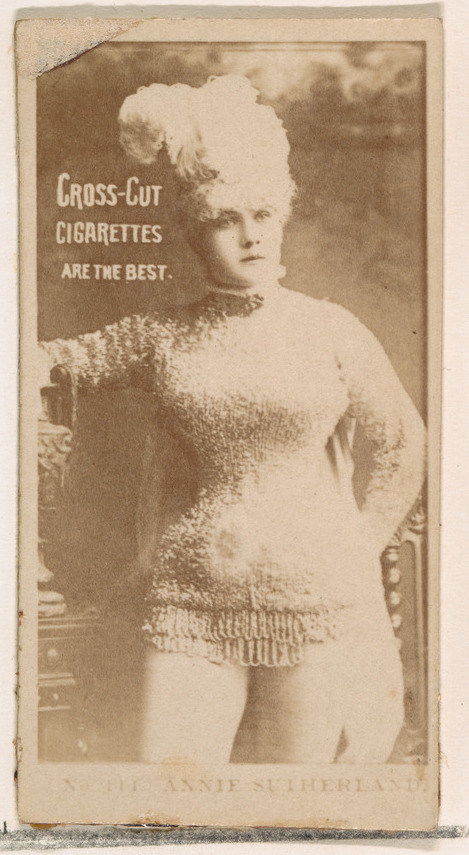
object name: print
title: Annie Sutherland, from the Actors and Actresses series (N145-2) issued by Duke Sons & Co. to promote Cross Cut Cigarettes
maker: w. duke, sons & co.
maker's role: publisher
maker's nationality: american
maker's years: 1870-1920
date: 1880-1889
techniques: albumen silver print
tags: portraits,women,actresses